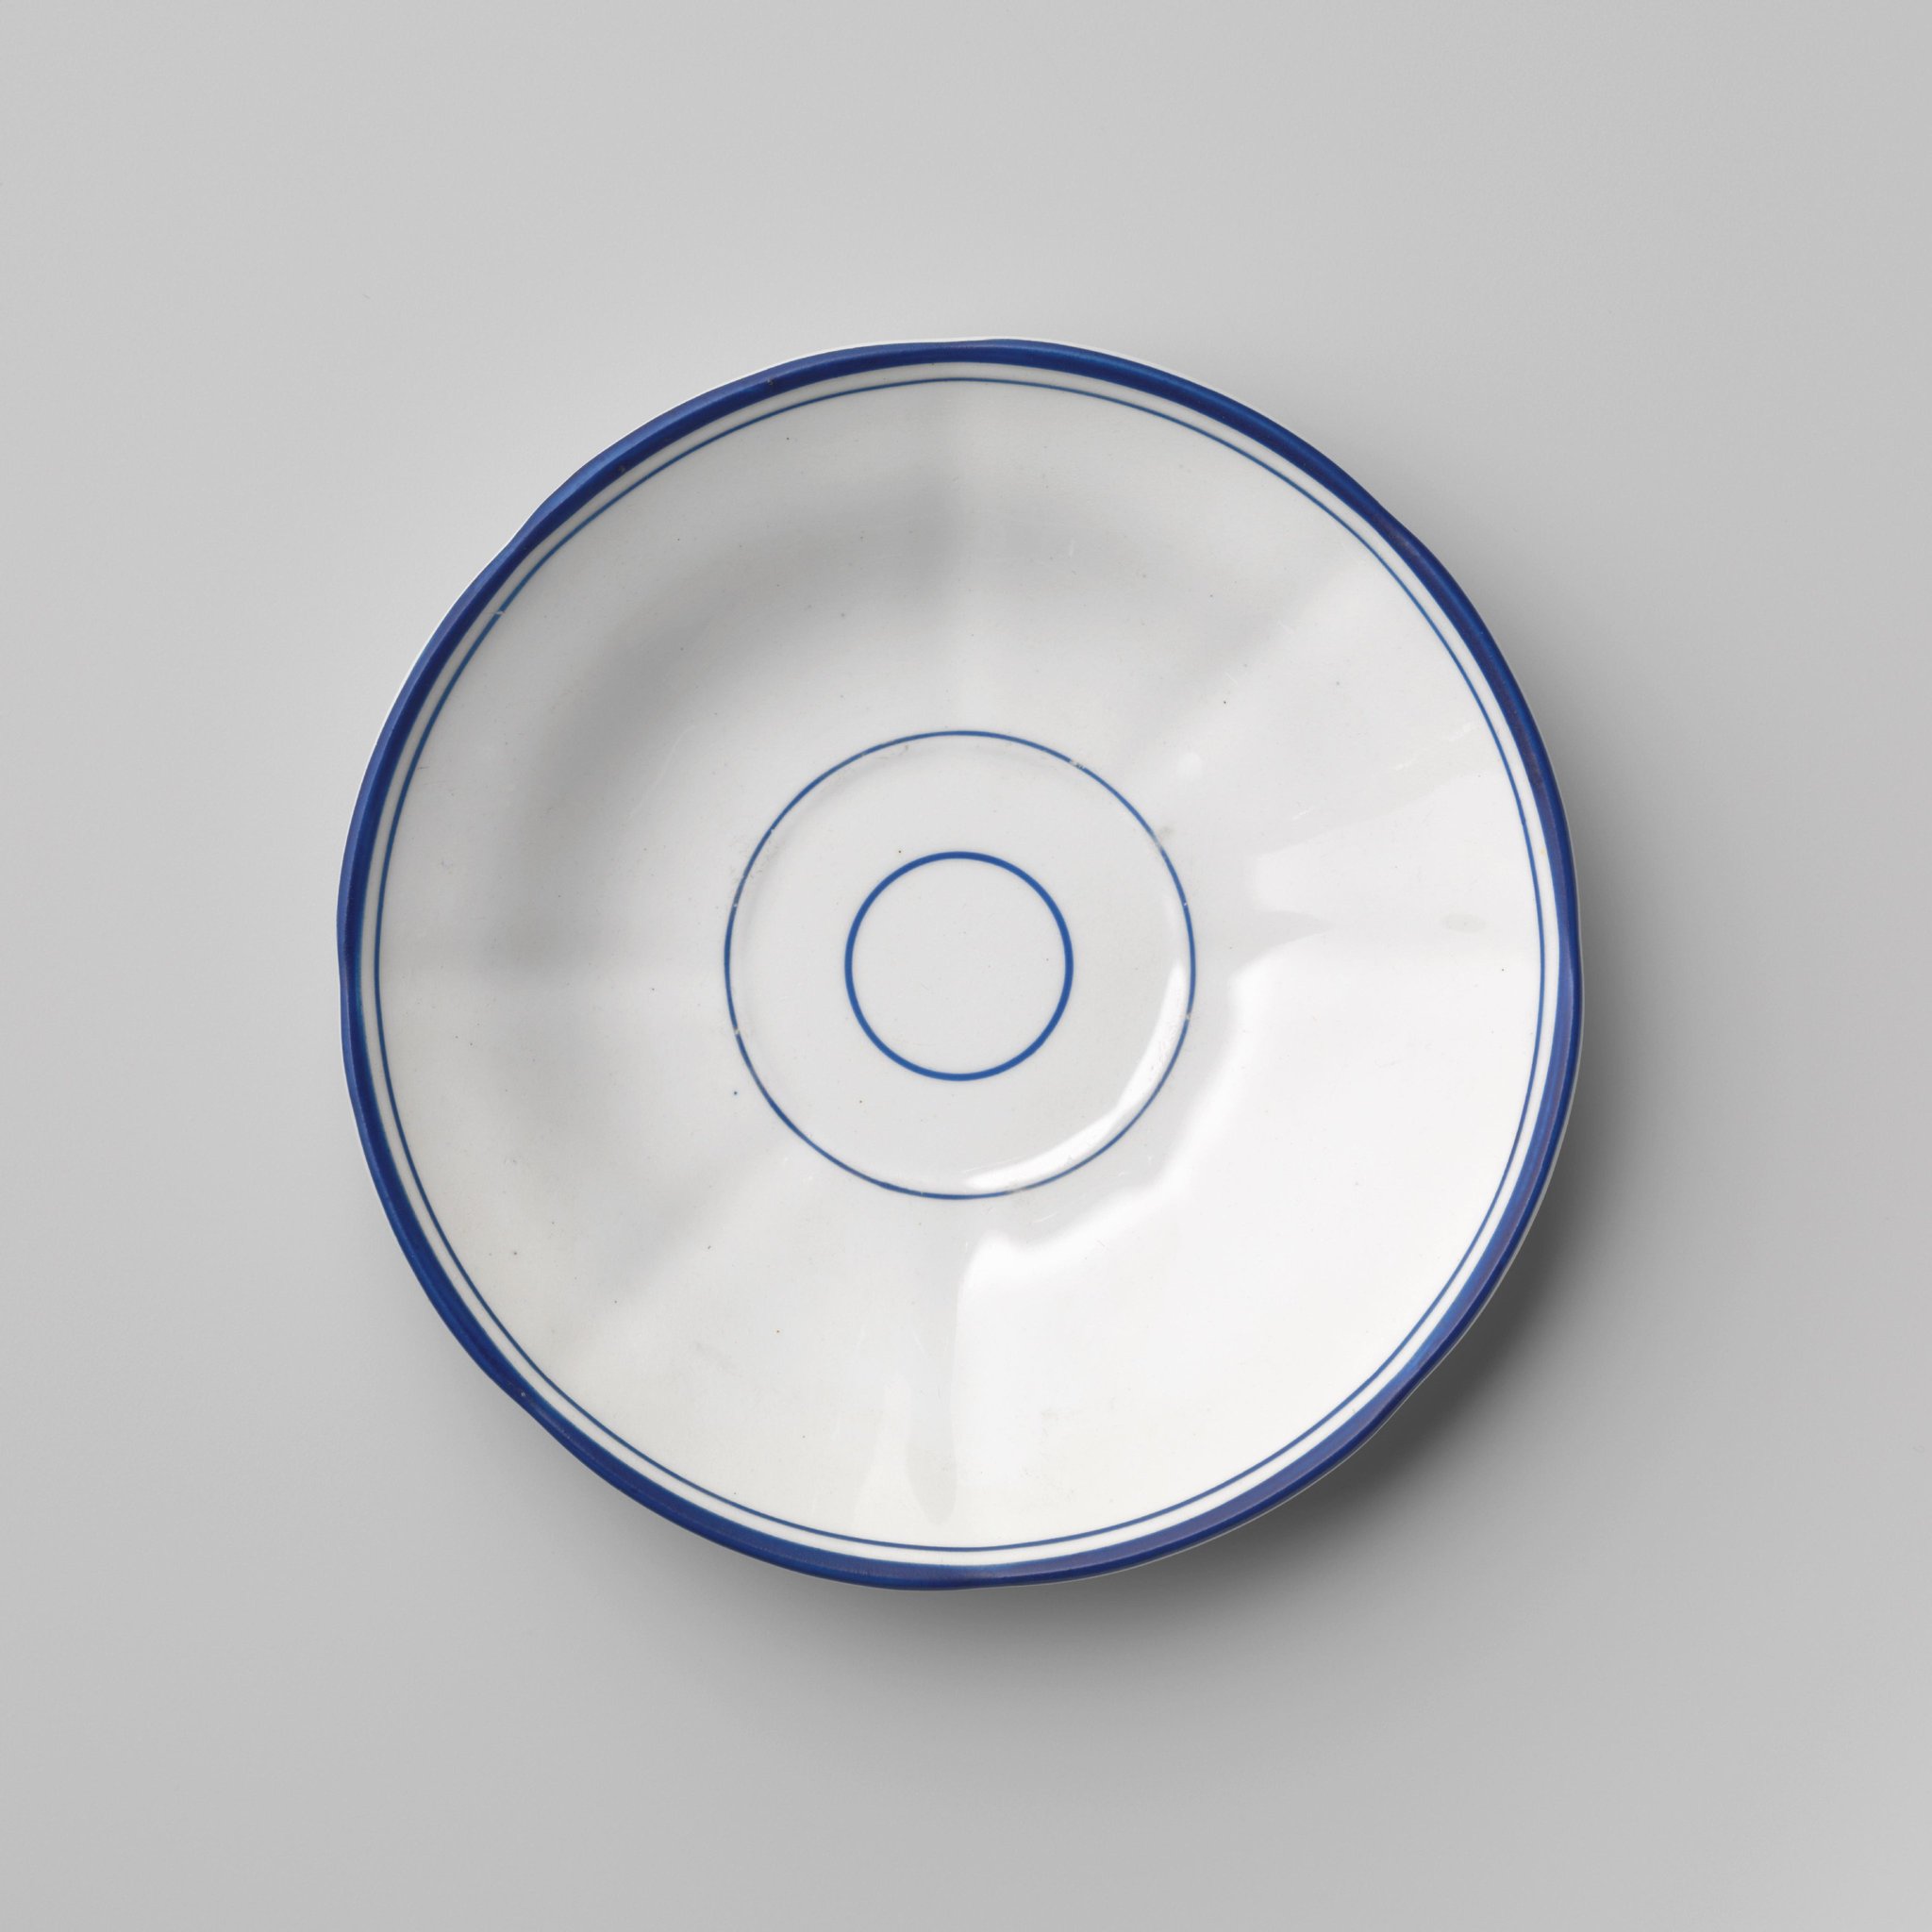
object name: platter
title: Schotel, wit, met blauwe biezen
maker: petrus regout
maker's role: plateelbakker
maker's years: 1801-1879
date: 1860-1890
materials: creamware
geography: maastricht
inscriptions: check stamp: ‘P. REGOUT // MAASTRICHT // 10X’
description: Schotel van aardewerk, behorend bij een koffie- en theeservies, wit, met blauwe biezen op het plat en de rand.